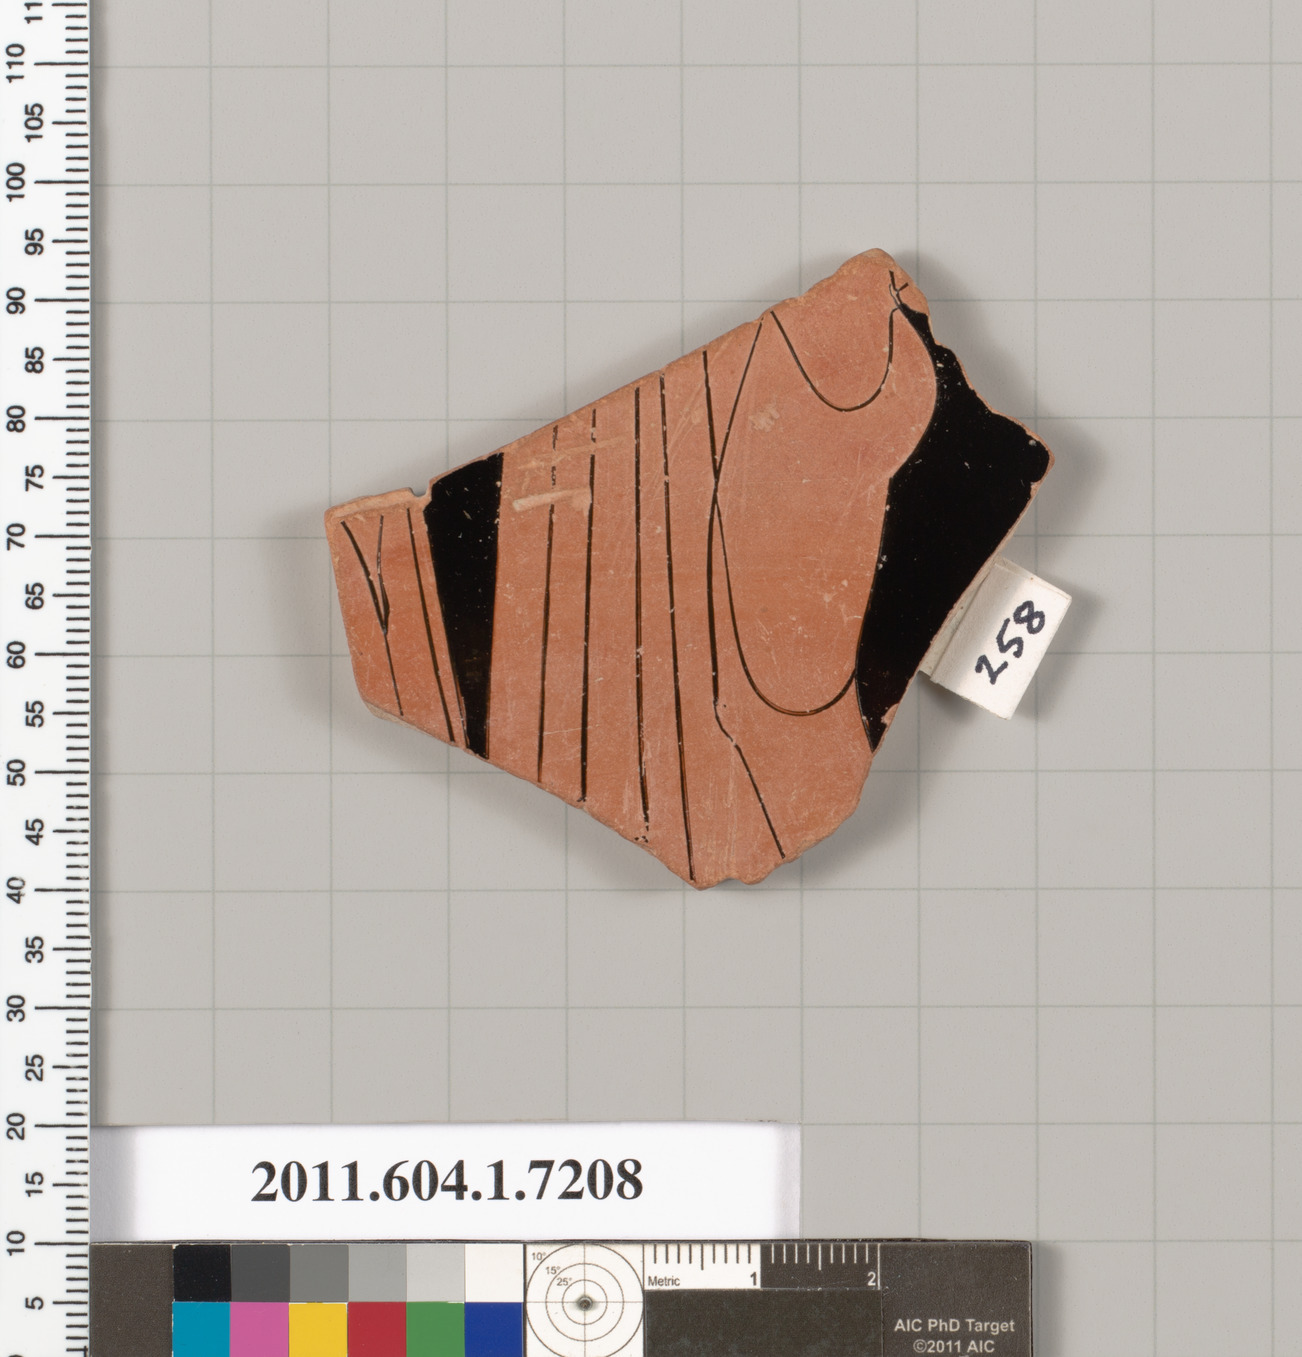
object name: kylix fragment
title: Terracotta fragment of a kylix (drinking cup)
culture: greek, attic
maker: makron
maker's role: artist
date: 500-480 BCE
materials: terracotta